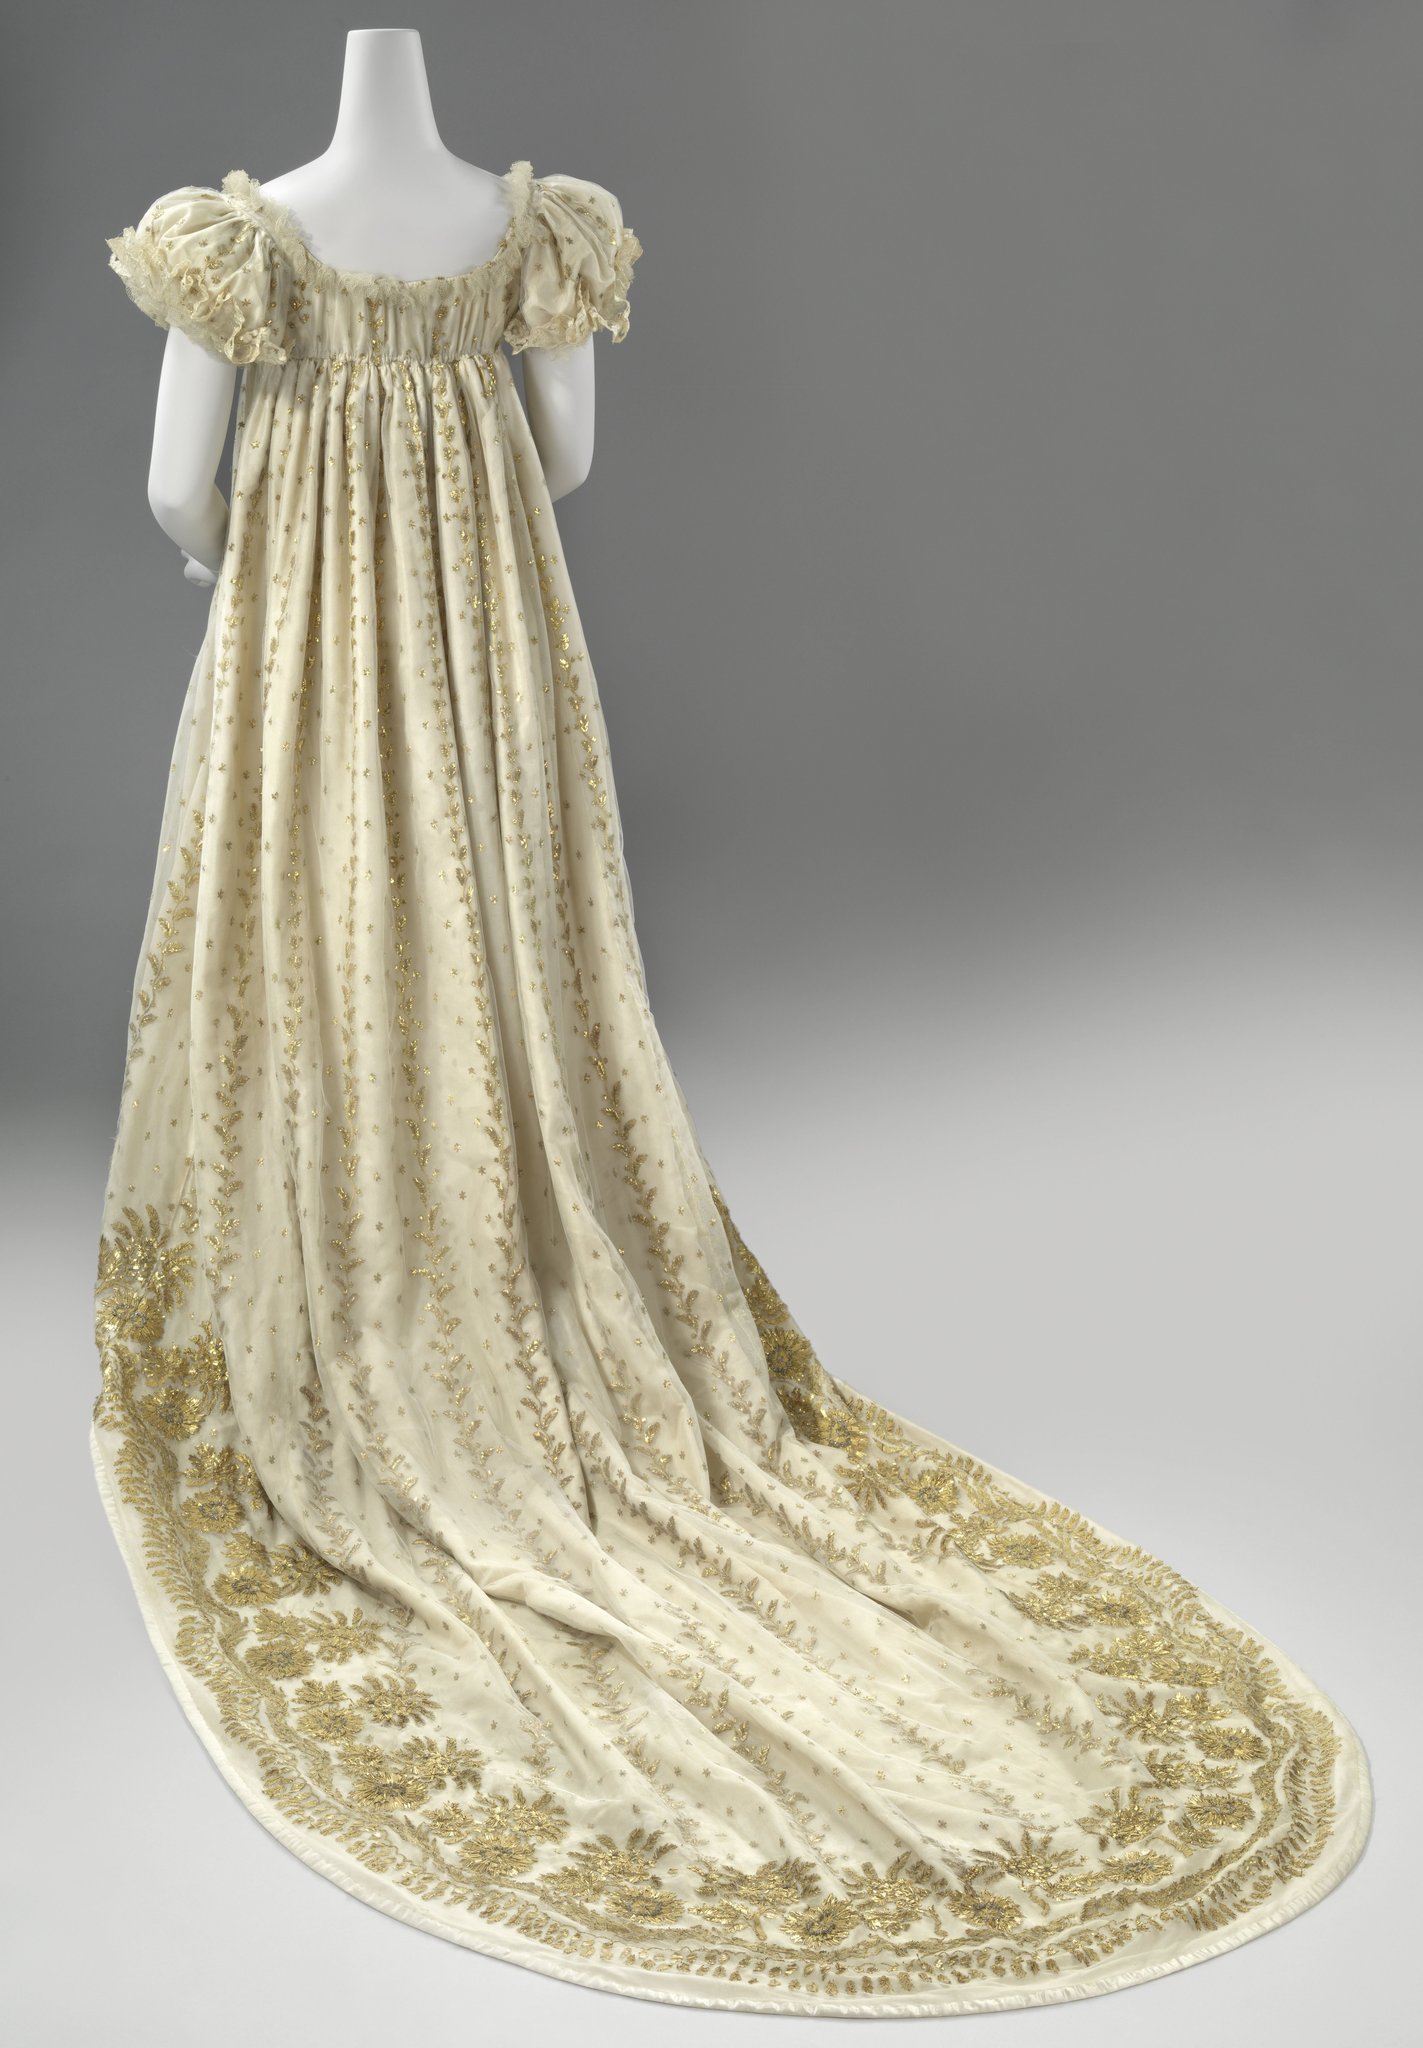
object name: avondkleding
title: Gown with a train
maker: Anonymous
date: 1808-1812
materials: copper, silk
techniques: weave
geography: france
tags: louis napoleon (king of holland), amsterdam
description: To meet the strict requirements set by the court in Paris, a court gown had to be decorated with gold lamé (thin strips of gold). This gown – meant to be worn at the court of Louis Napoleon in the Netherlands – is worked ‘merely’ with gilt brass. The accompanying silk stockings and shoes are also on view in this gallery.